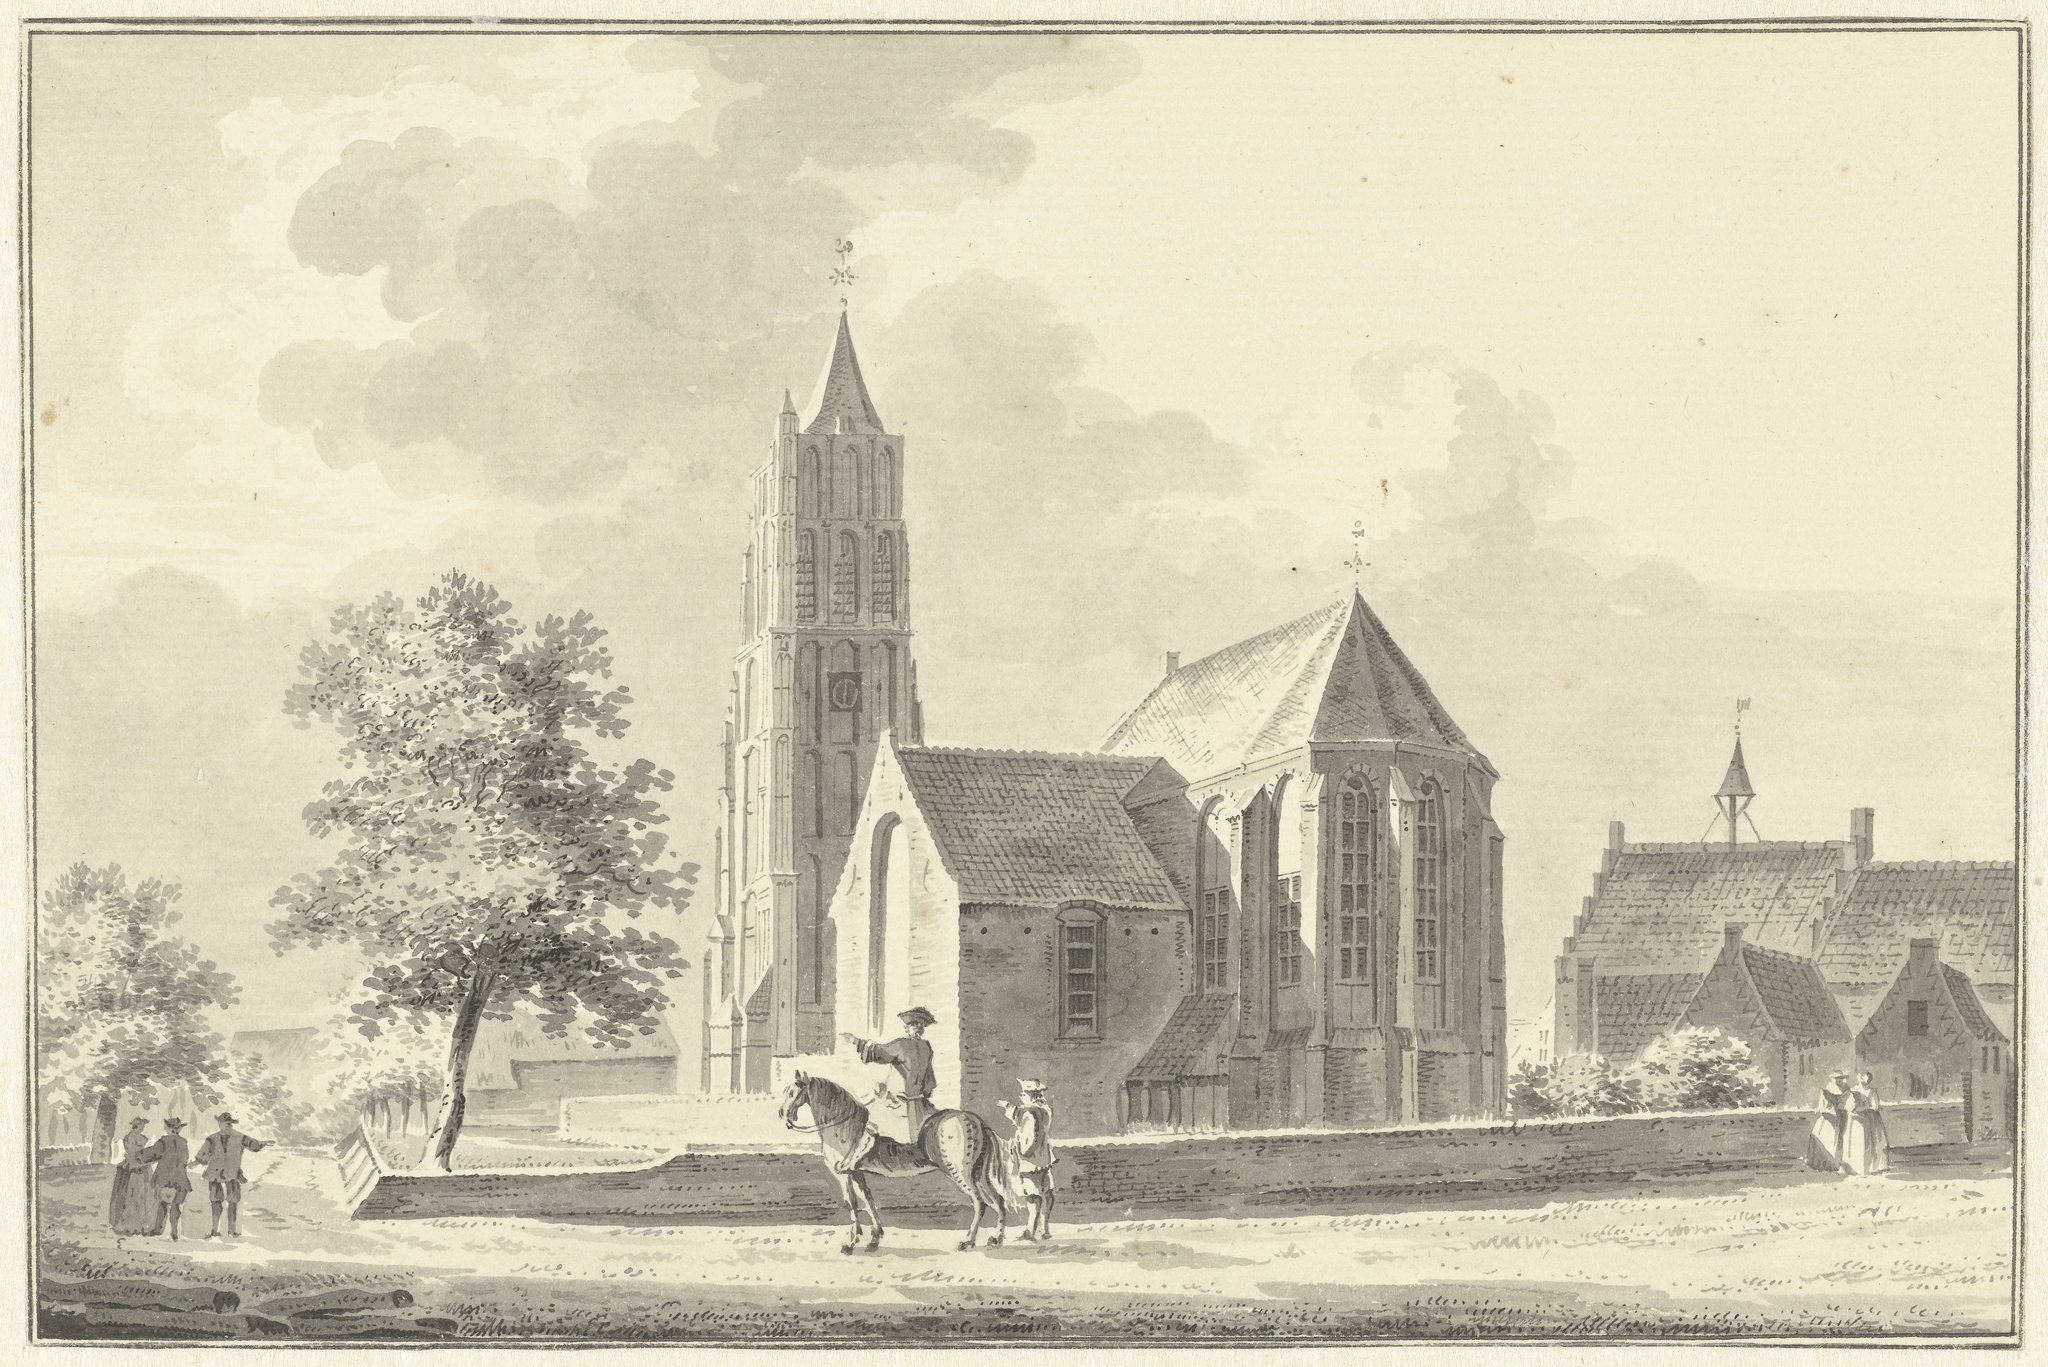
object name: drawing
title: Kerk en stadhuis te Heukelom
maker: pieter jan van liender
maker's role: print maker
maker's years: 1727-1779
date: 1756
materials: ink, paper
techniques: brush, pen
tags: church (exterior), townhall